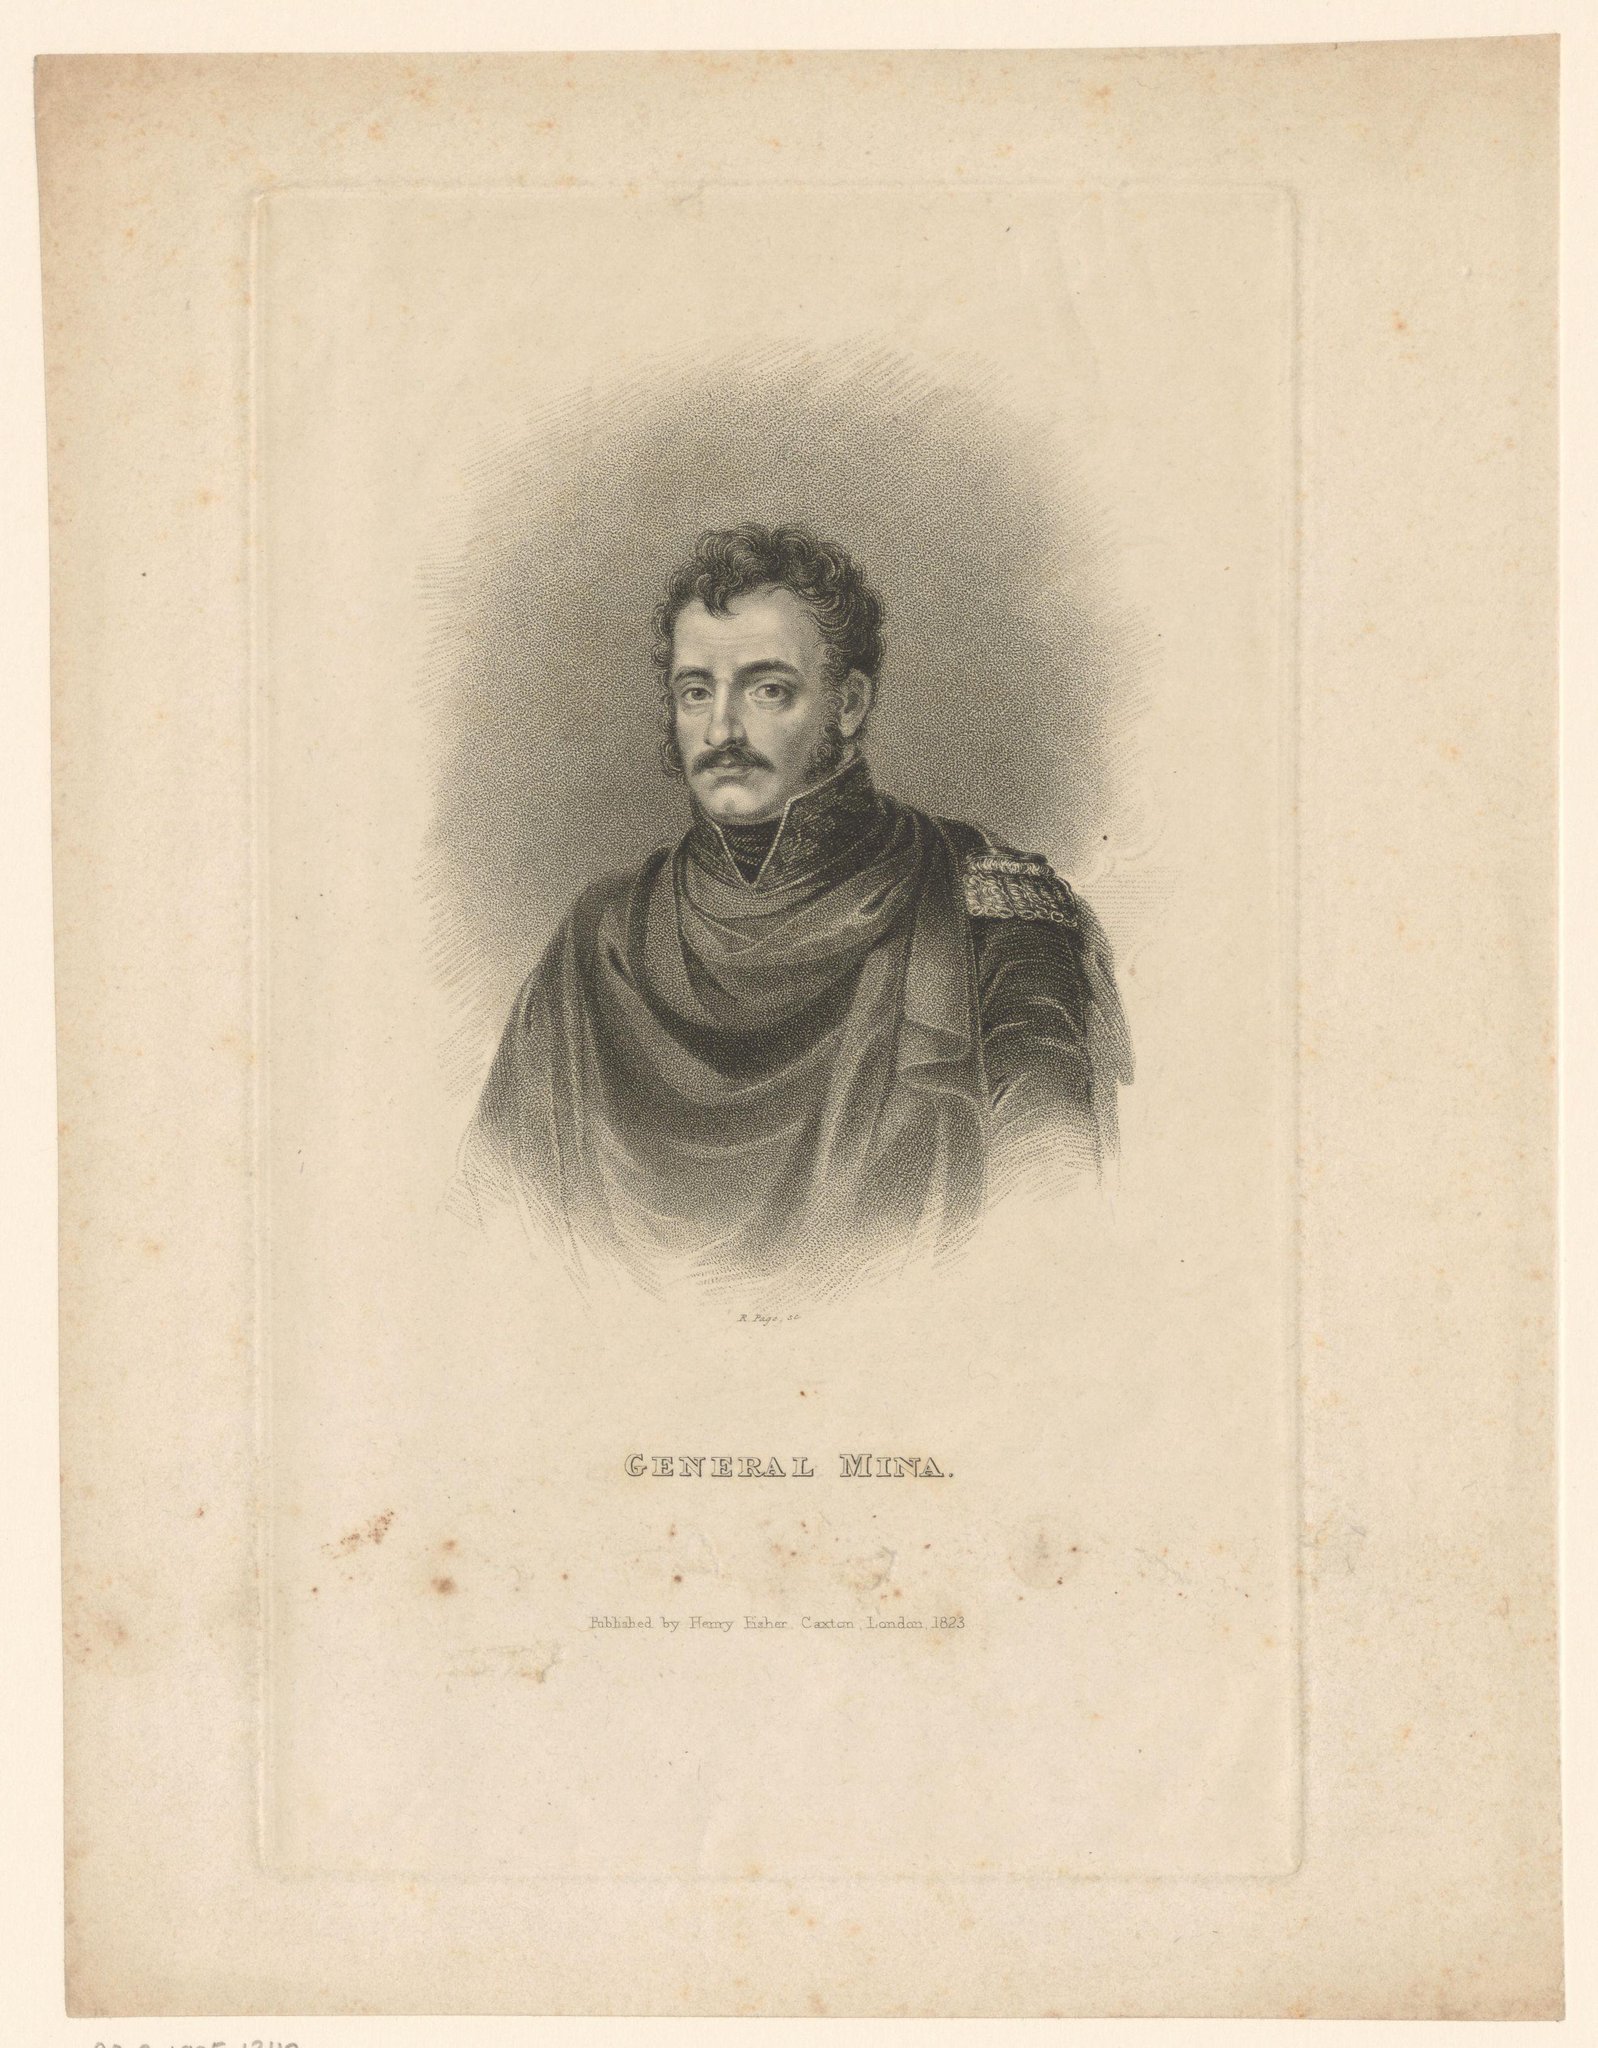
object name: print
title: General Mina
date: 1823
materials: paper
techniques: roulette, engraving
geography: london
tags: commander-in-chief, general, marshal, historical persons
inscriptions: collector's mark: Lugt 2228